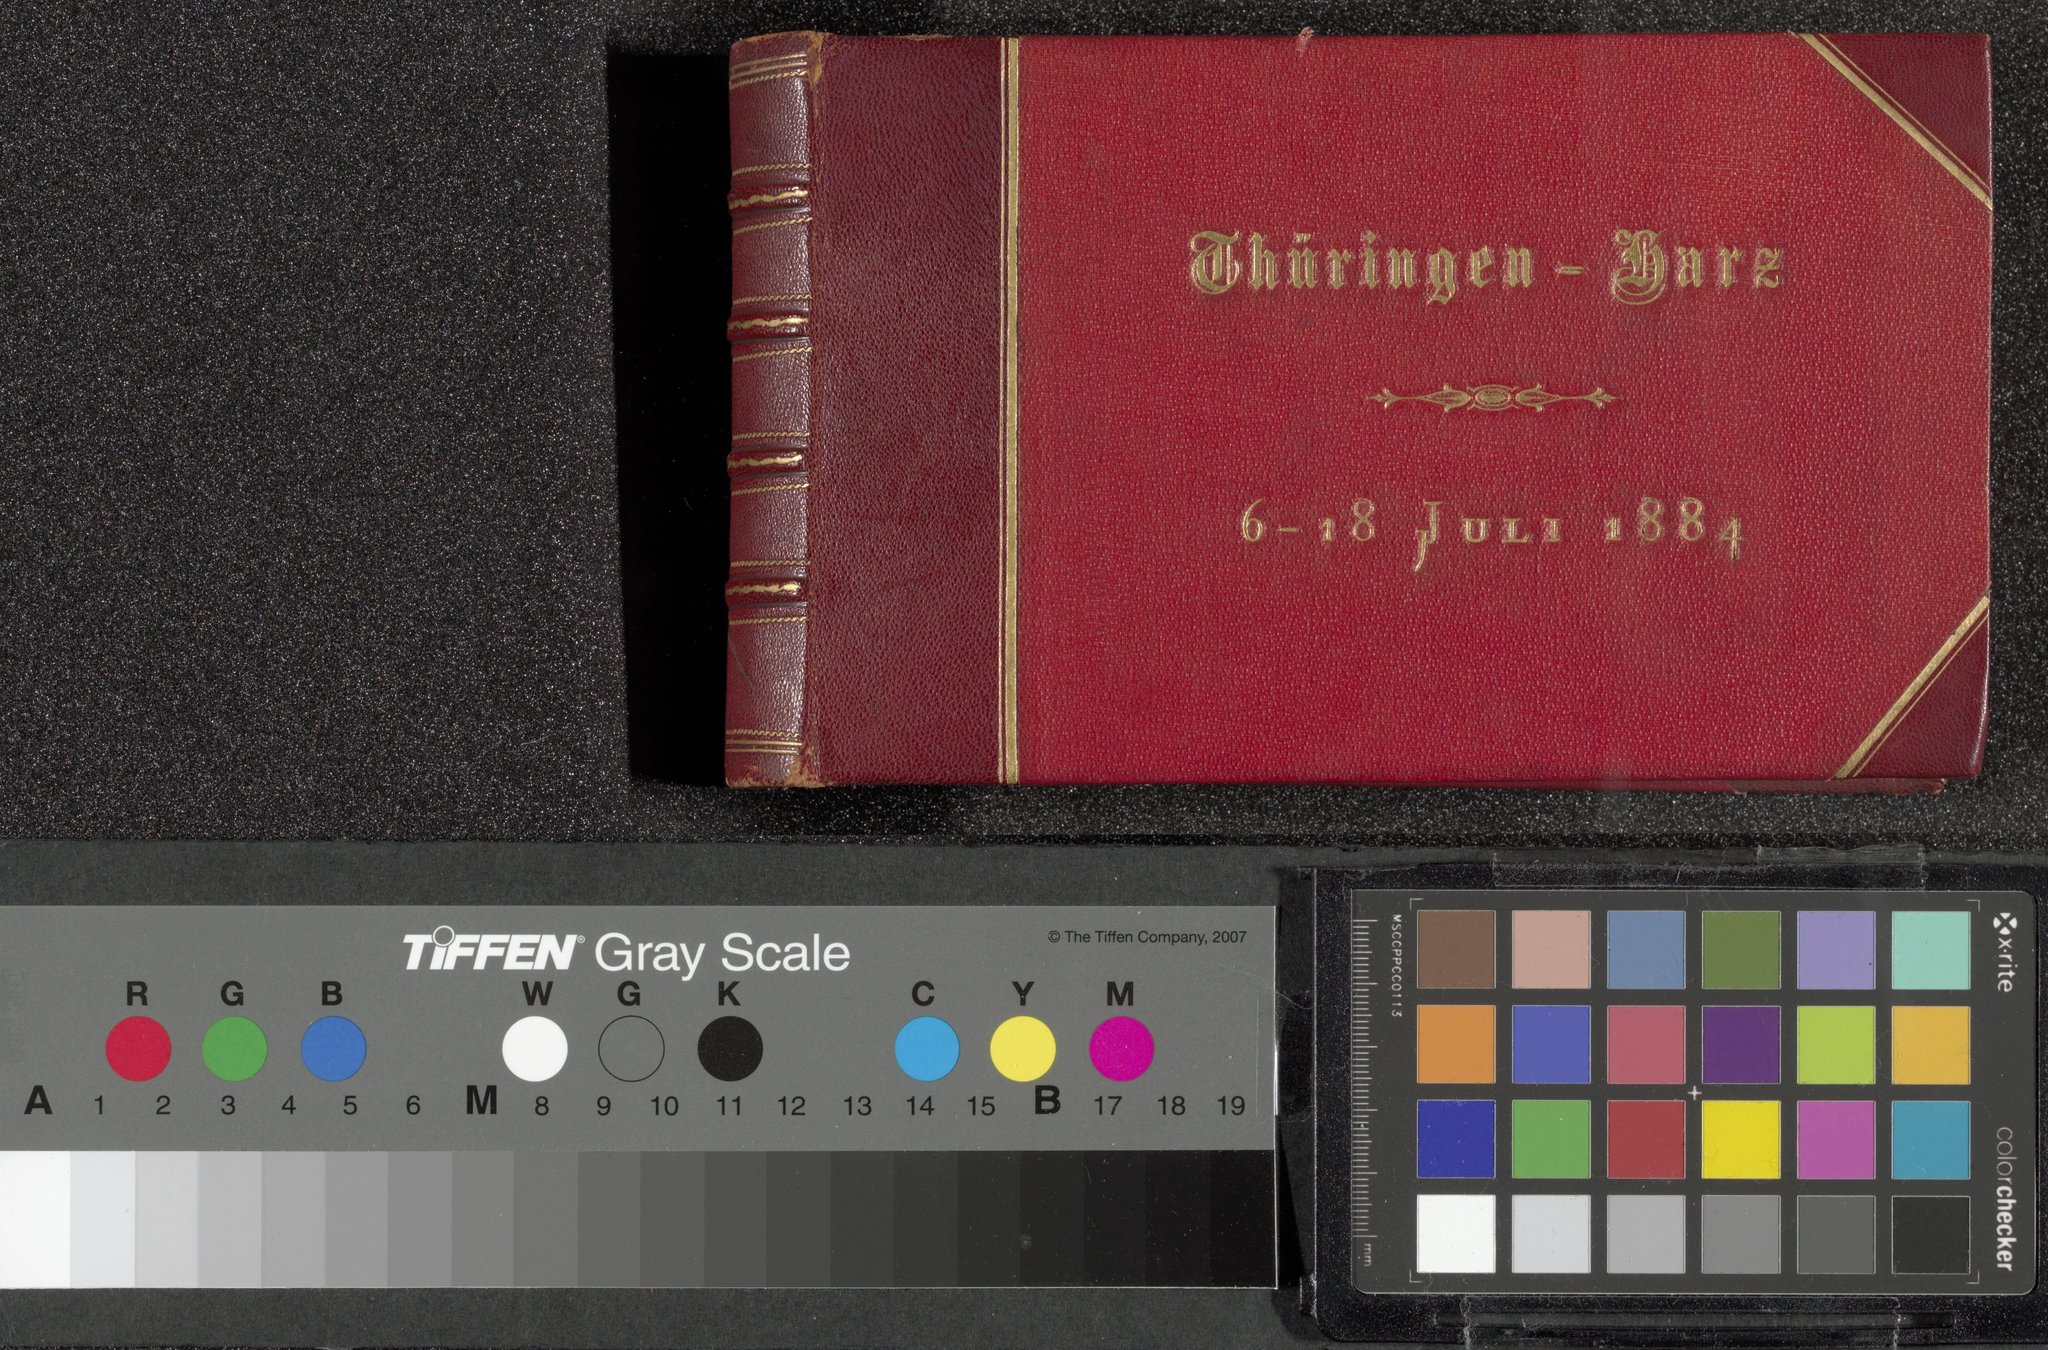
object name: photograph album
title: Thüringen-Harz 6-18 Juli 1884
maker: Anonymous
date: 1807-1884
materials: cardboard, leather, paper, textile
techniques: albumen print, photograph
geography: netherlands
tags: travelling; tourism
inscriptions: inscription: ‘Gebr: Winkelhagen hof-leveranciers Vijzelstr. 72. Amsterdam.’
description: Fotoalbum in rode omslag met leren rug en hoekpunten. Schutbladen zijn van changeant papier. Het album bevat 38 kabinetfoto's die aan één zijde zijn vastgelijmd aan de boekblokrug. Het betreft opnames van bezienswaardigheden in de Harz (Duitsland): landschappen, dorpsgezichten, gebouwen. Ook twee opnames van bustes van Schiller en Goethe. Het album is samengesteld door een onbekende, vermoedelijk Amsterdamse reiziger.